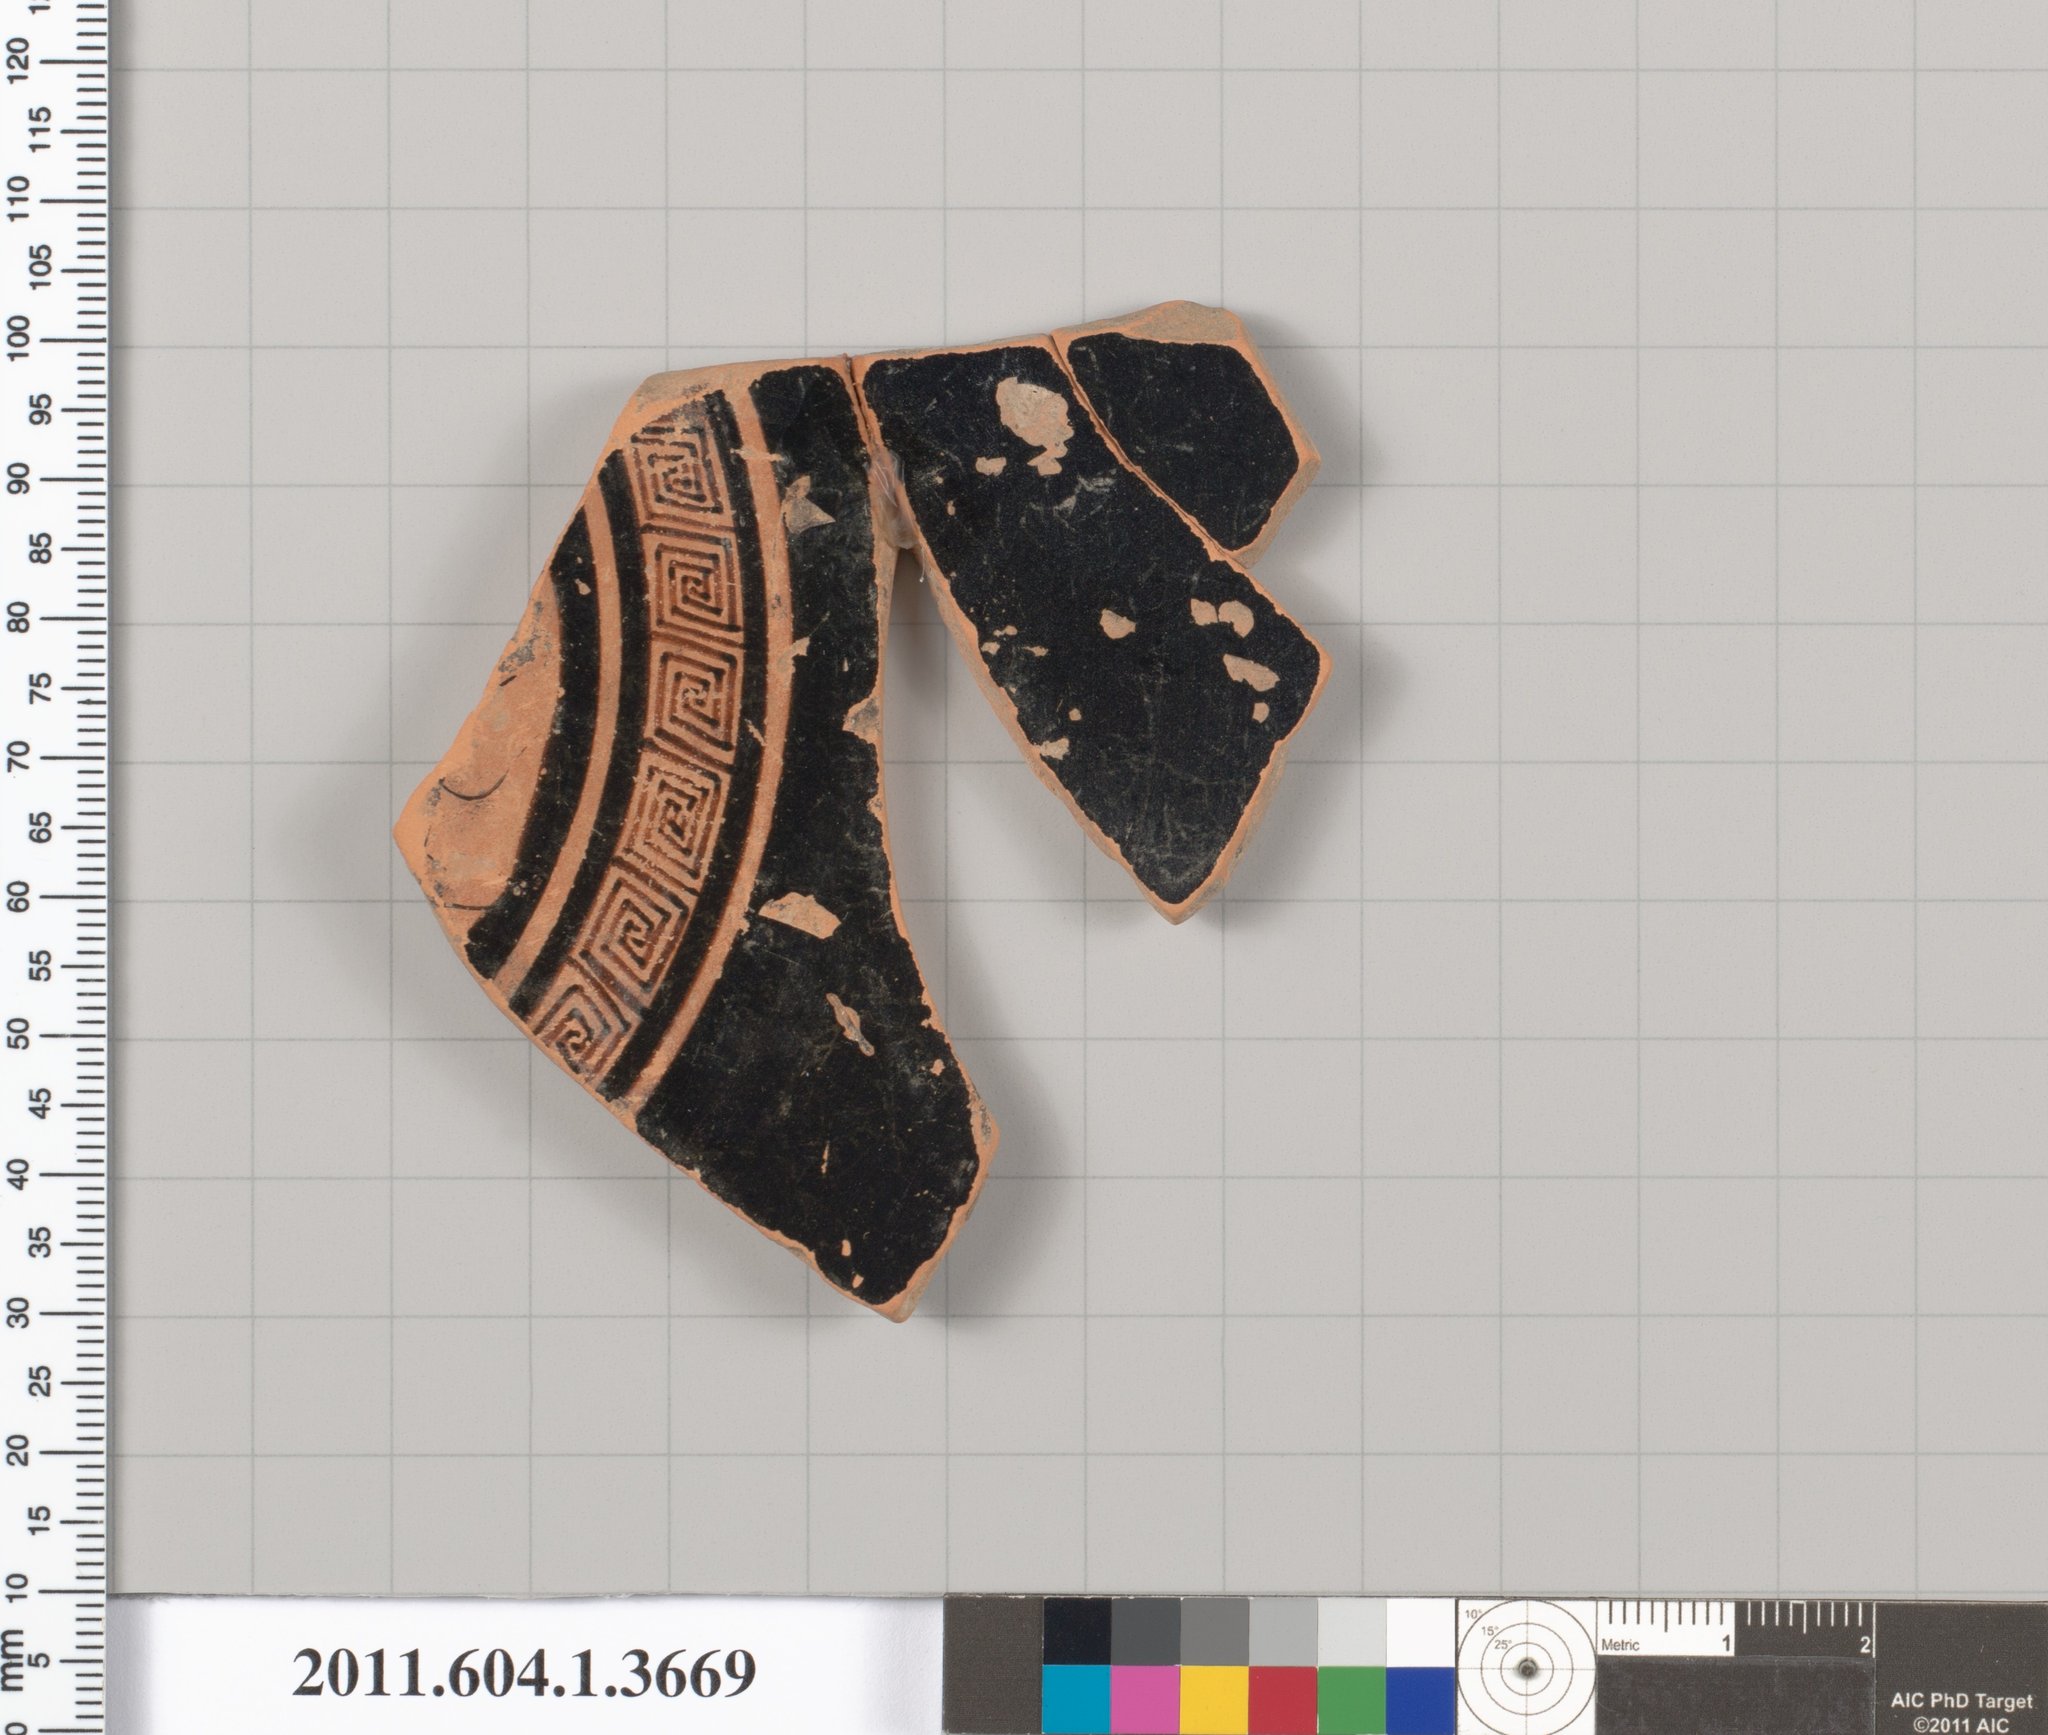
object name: kylix fragment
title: Terracotta fragment of a kylix (drinking cup)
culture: greek, attic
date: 475-451 BCE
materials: terracotta